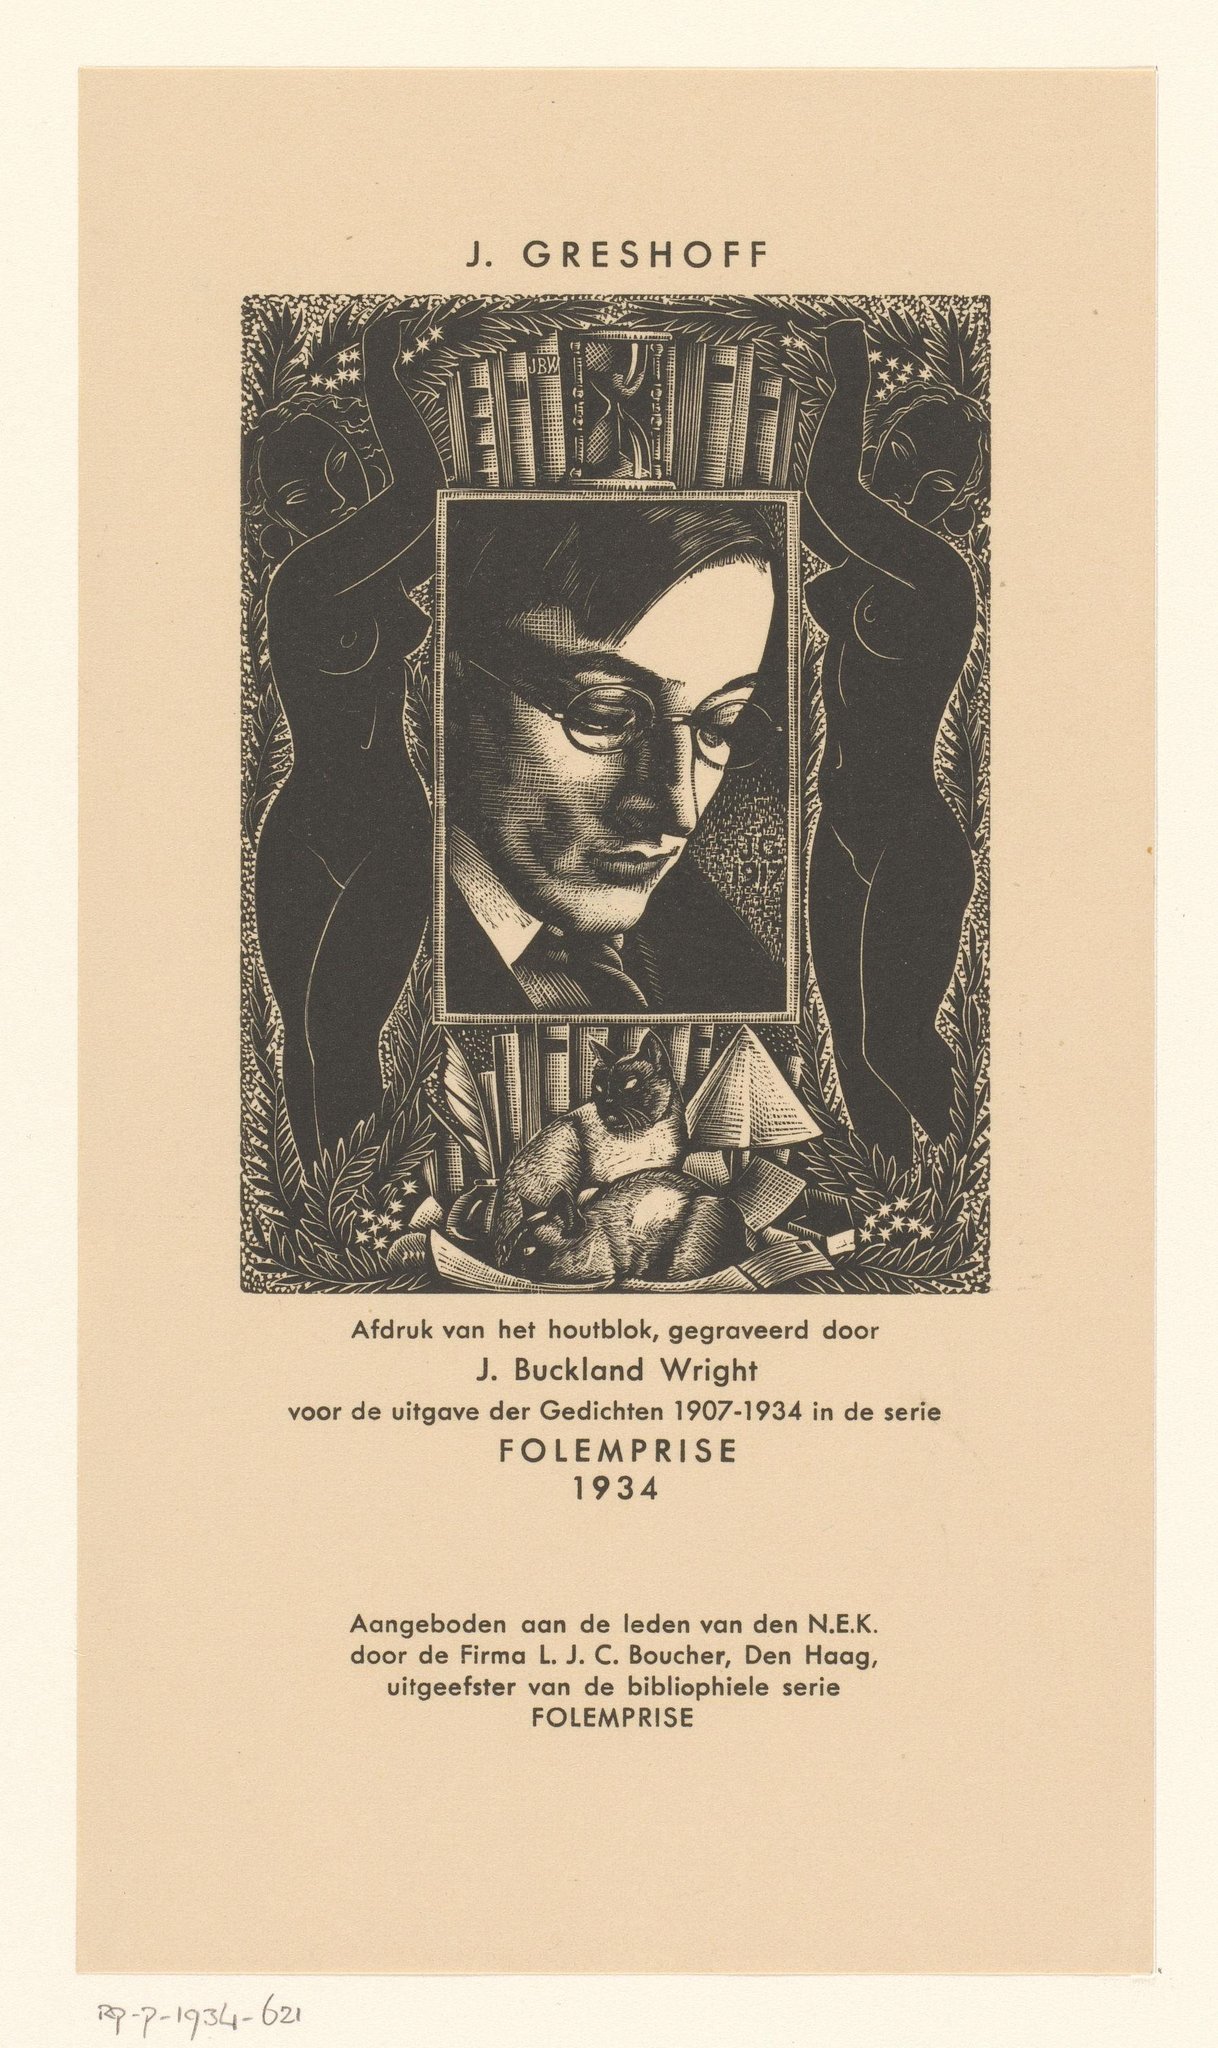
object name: print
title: Portret van Jan Greshoff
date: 1917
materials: paper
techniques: letterpress printing, engraving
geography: the hague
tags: print maker, jan greshoff, cat, portrait of a writer, the (nude) human figure; 'corpo humano' (ripa) - aa - female human figure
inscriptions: collector's mark: Lugt 2228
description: In het midden een portret van Jan Greshoff, geflankeerd door twee naakte vrouwen. Bovenaan een rij boeken en een zandloper; onderaan zitten twee katten.